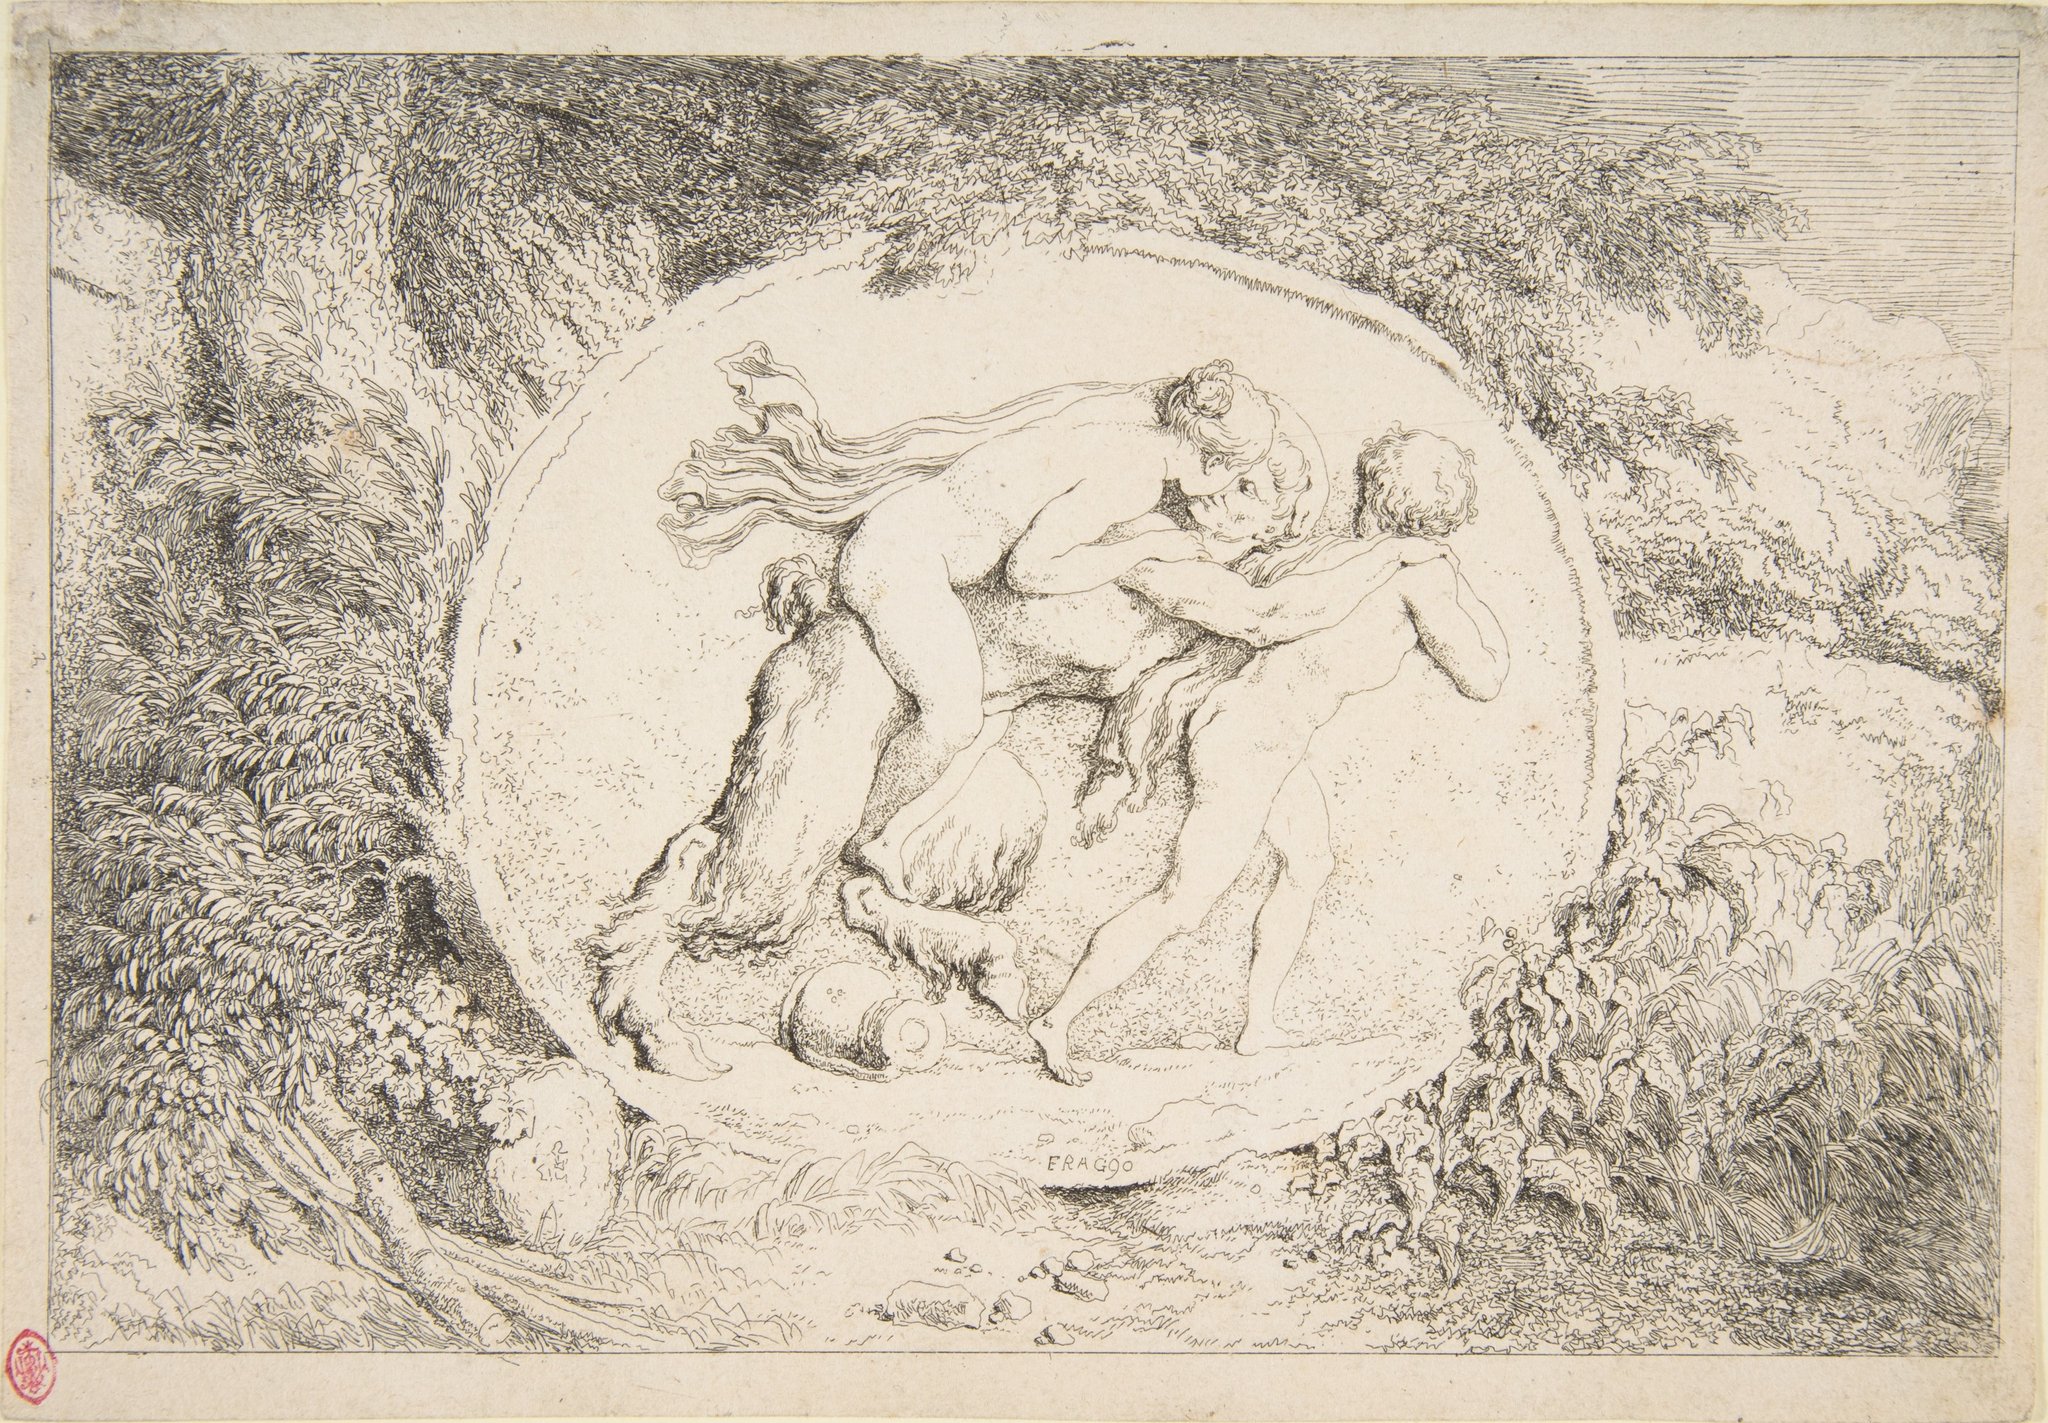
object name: print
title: A Young Girl Astride a Satyr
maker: jean honoré fragonard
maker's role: artist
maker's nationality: french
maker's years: 1732-1806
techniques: etching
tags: boys,girls,satyrs